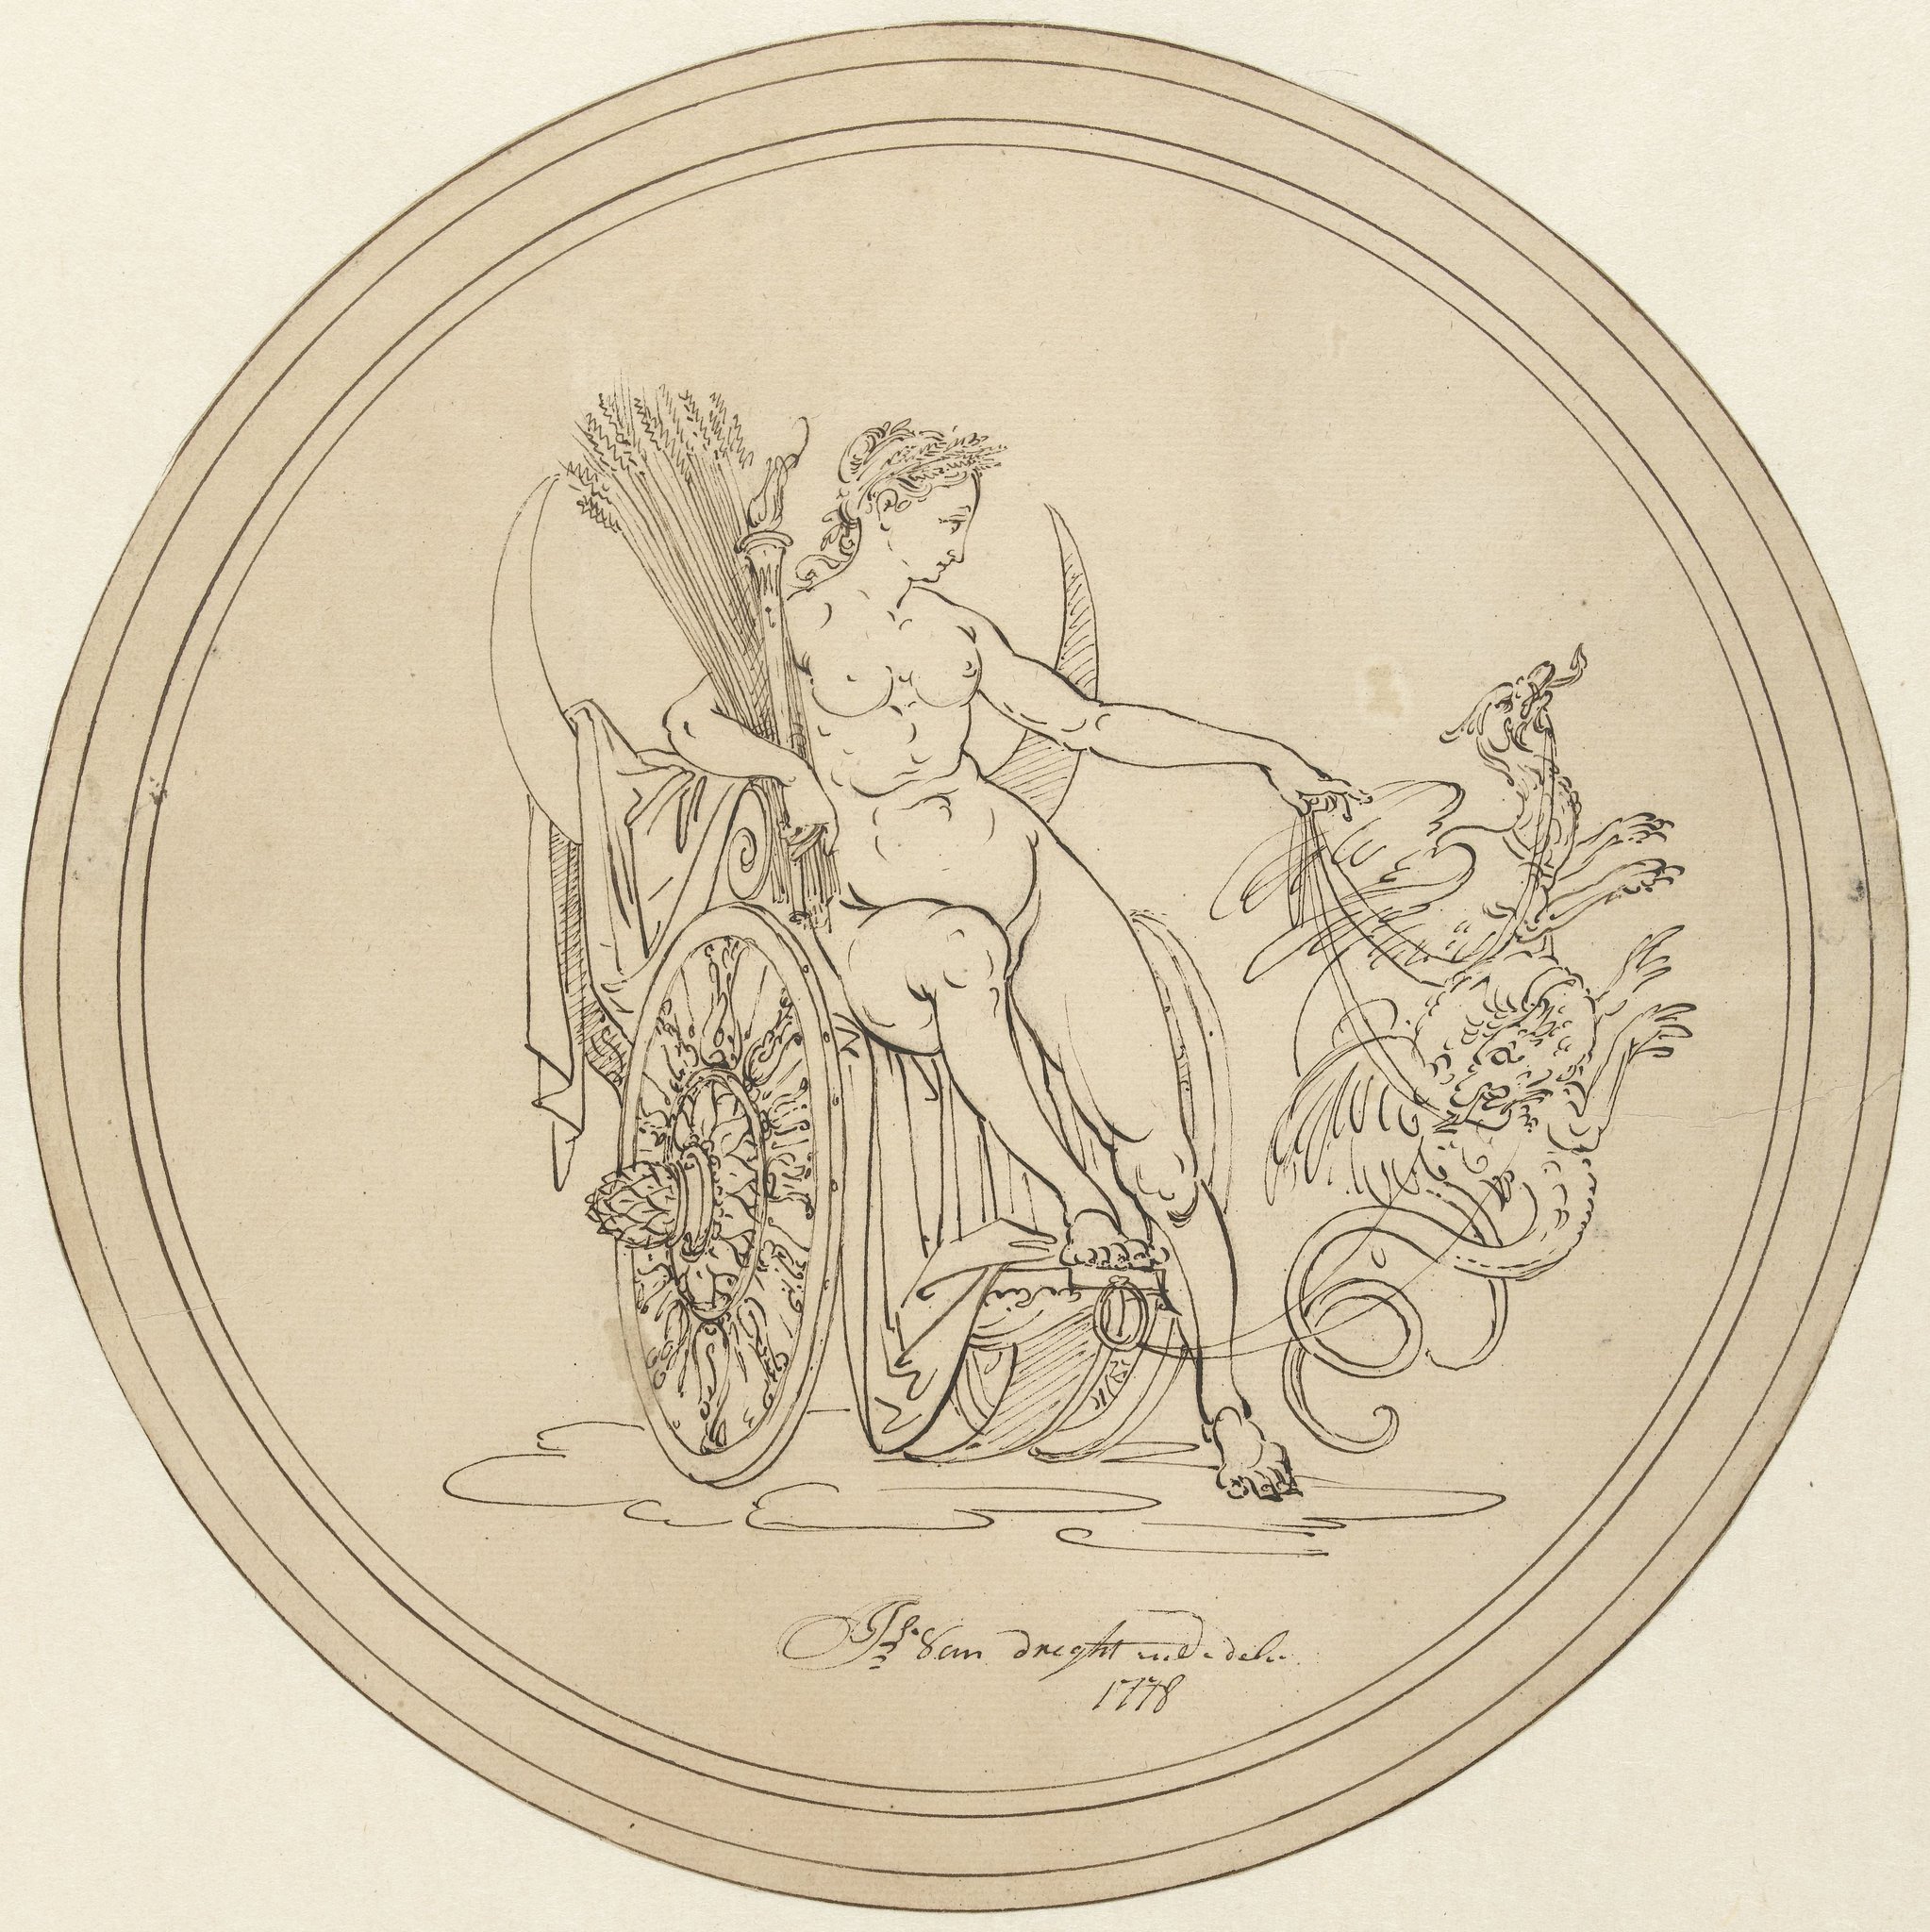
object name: drawing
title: Allegorische vrouwenfiguur, in triomfwagen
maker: johannes van dregt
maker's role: draughtsman, painter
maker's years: 1737-1807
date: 1778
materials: ink, paper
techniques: pen